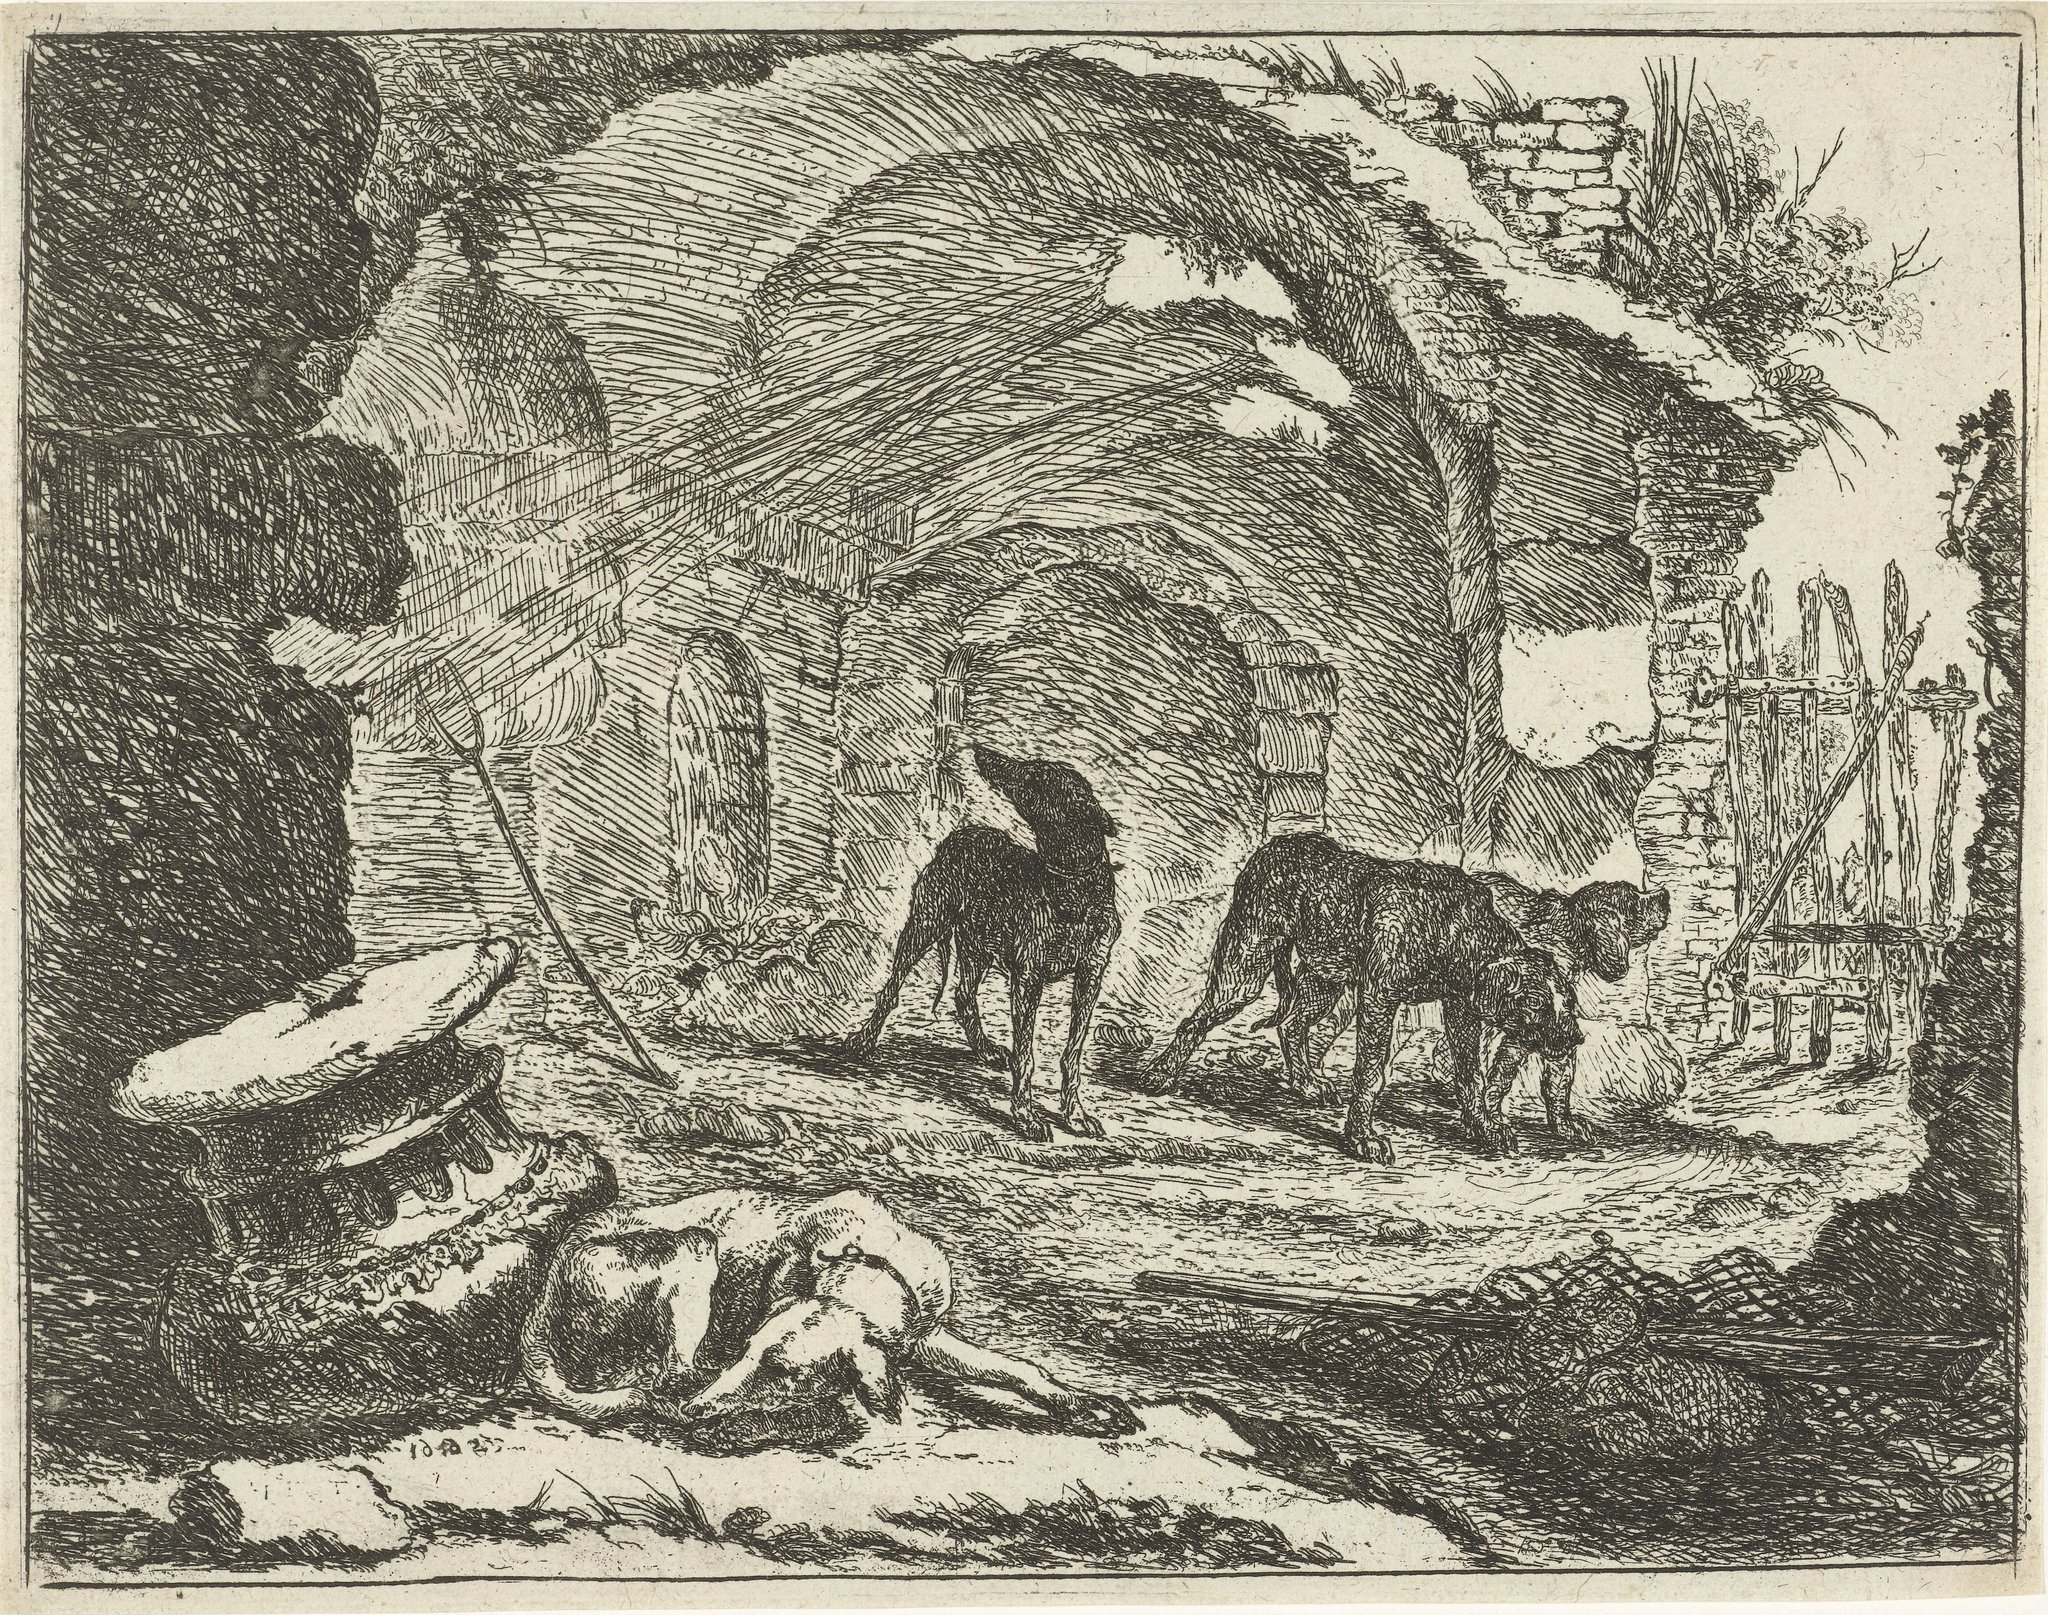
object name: print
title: Honden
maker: joannes fijt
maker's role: draughtsman, print maker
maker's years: 1611-1661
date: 1667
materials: paper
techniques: etching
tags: ruin of a dwelling, house, castle, etc., dog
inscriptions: collector's mark: Lugt 2228